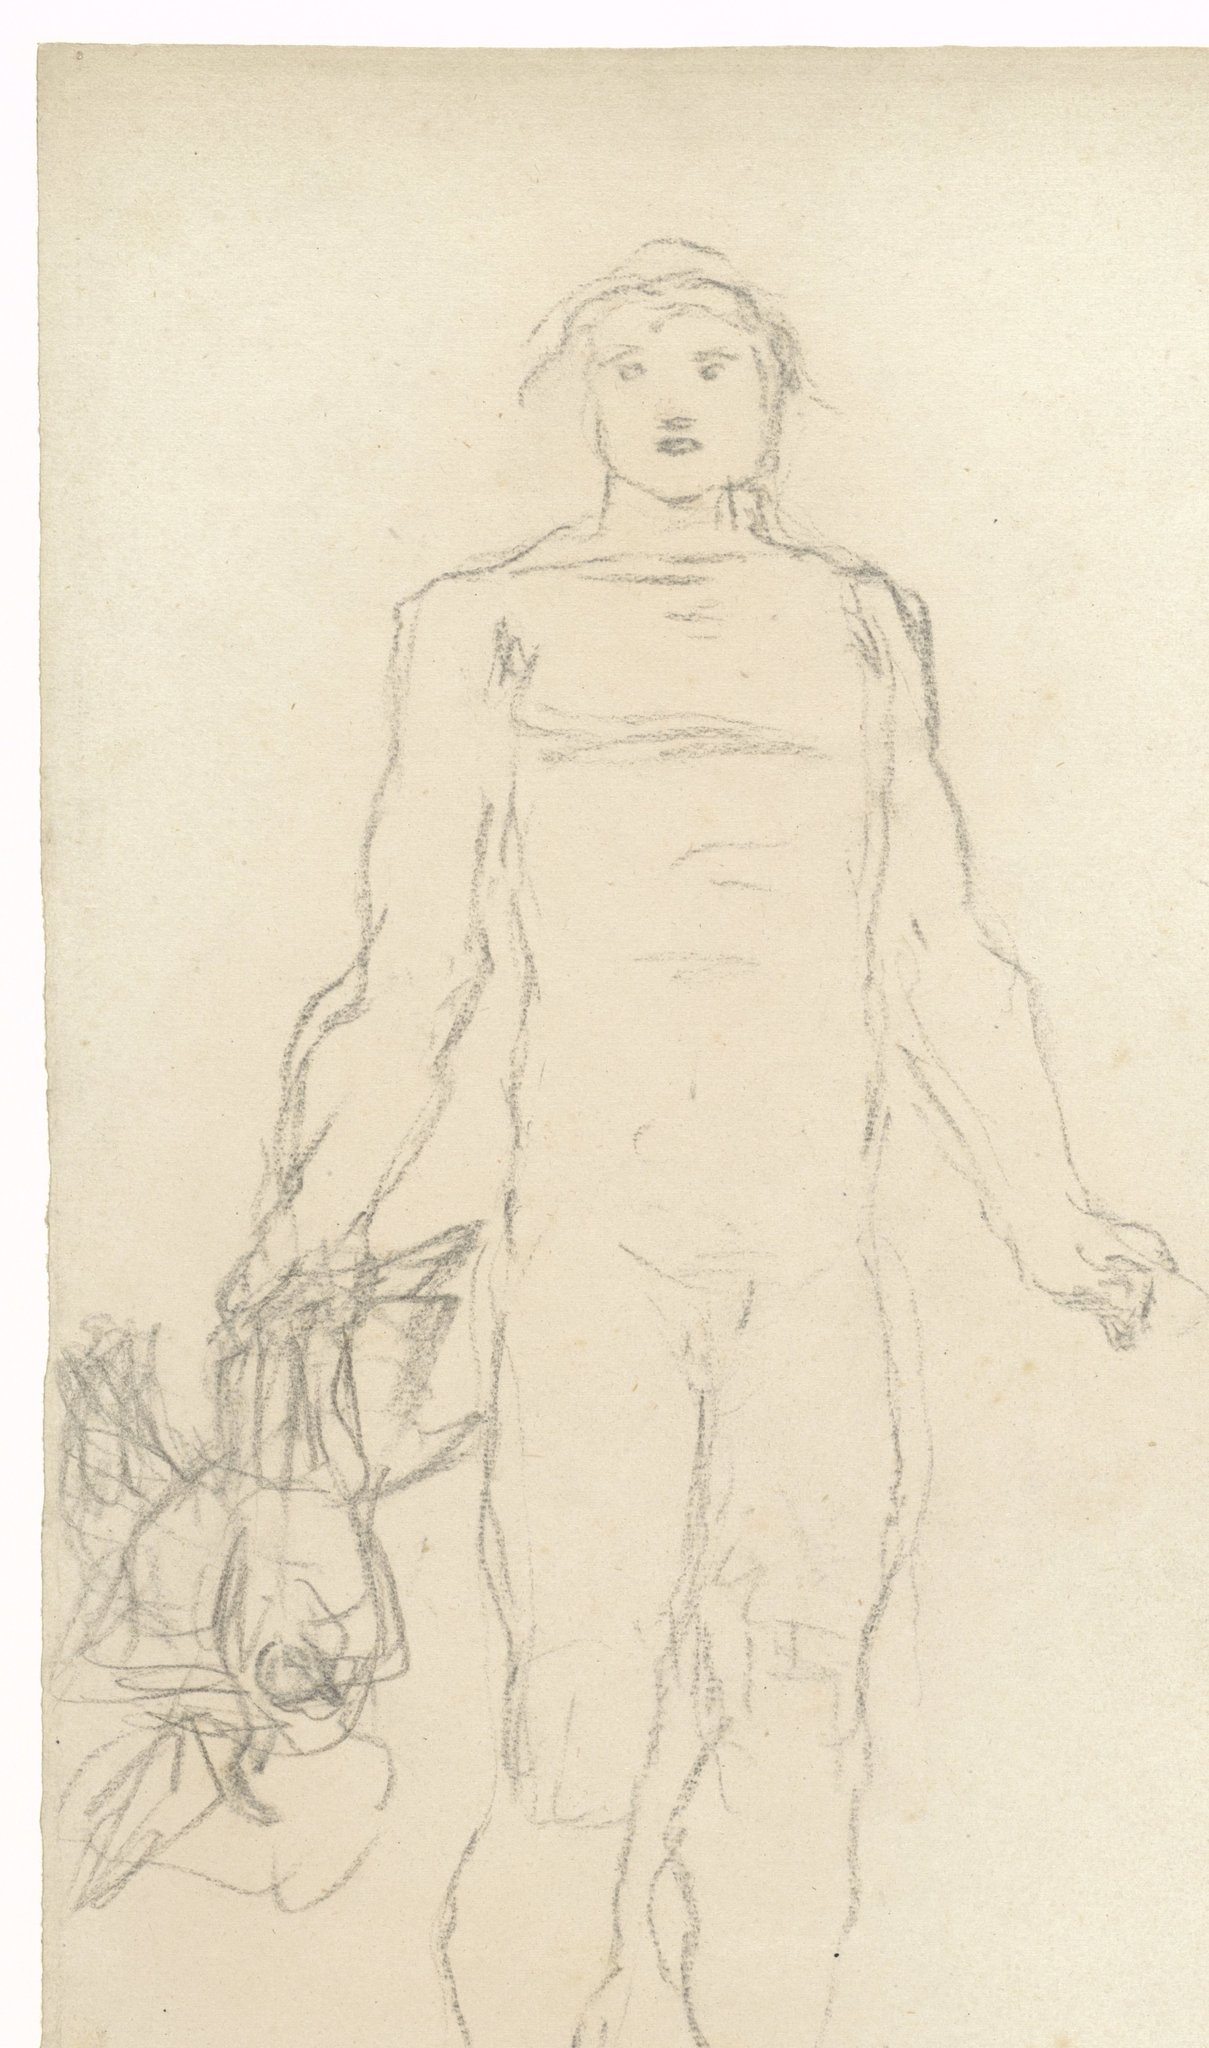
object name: drawing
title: Staande man met een vogel als offerdier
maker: matthijs maris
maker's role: draughtsman, painter, print maker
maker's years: 1839-1917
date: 1849-1917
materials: chalk, paper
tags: animal sacrifice ~ non-christian religions